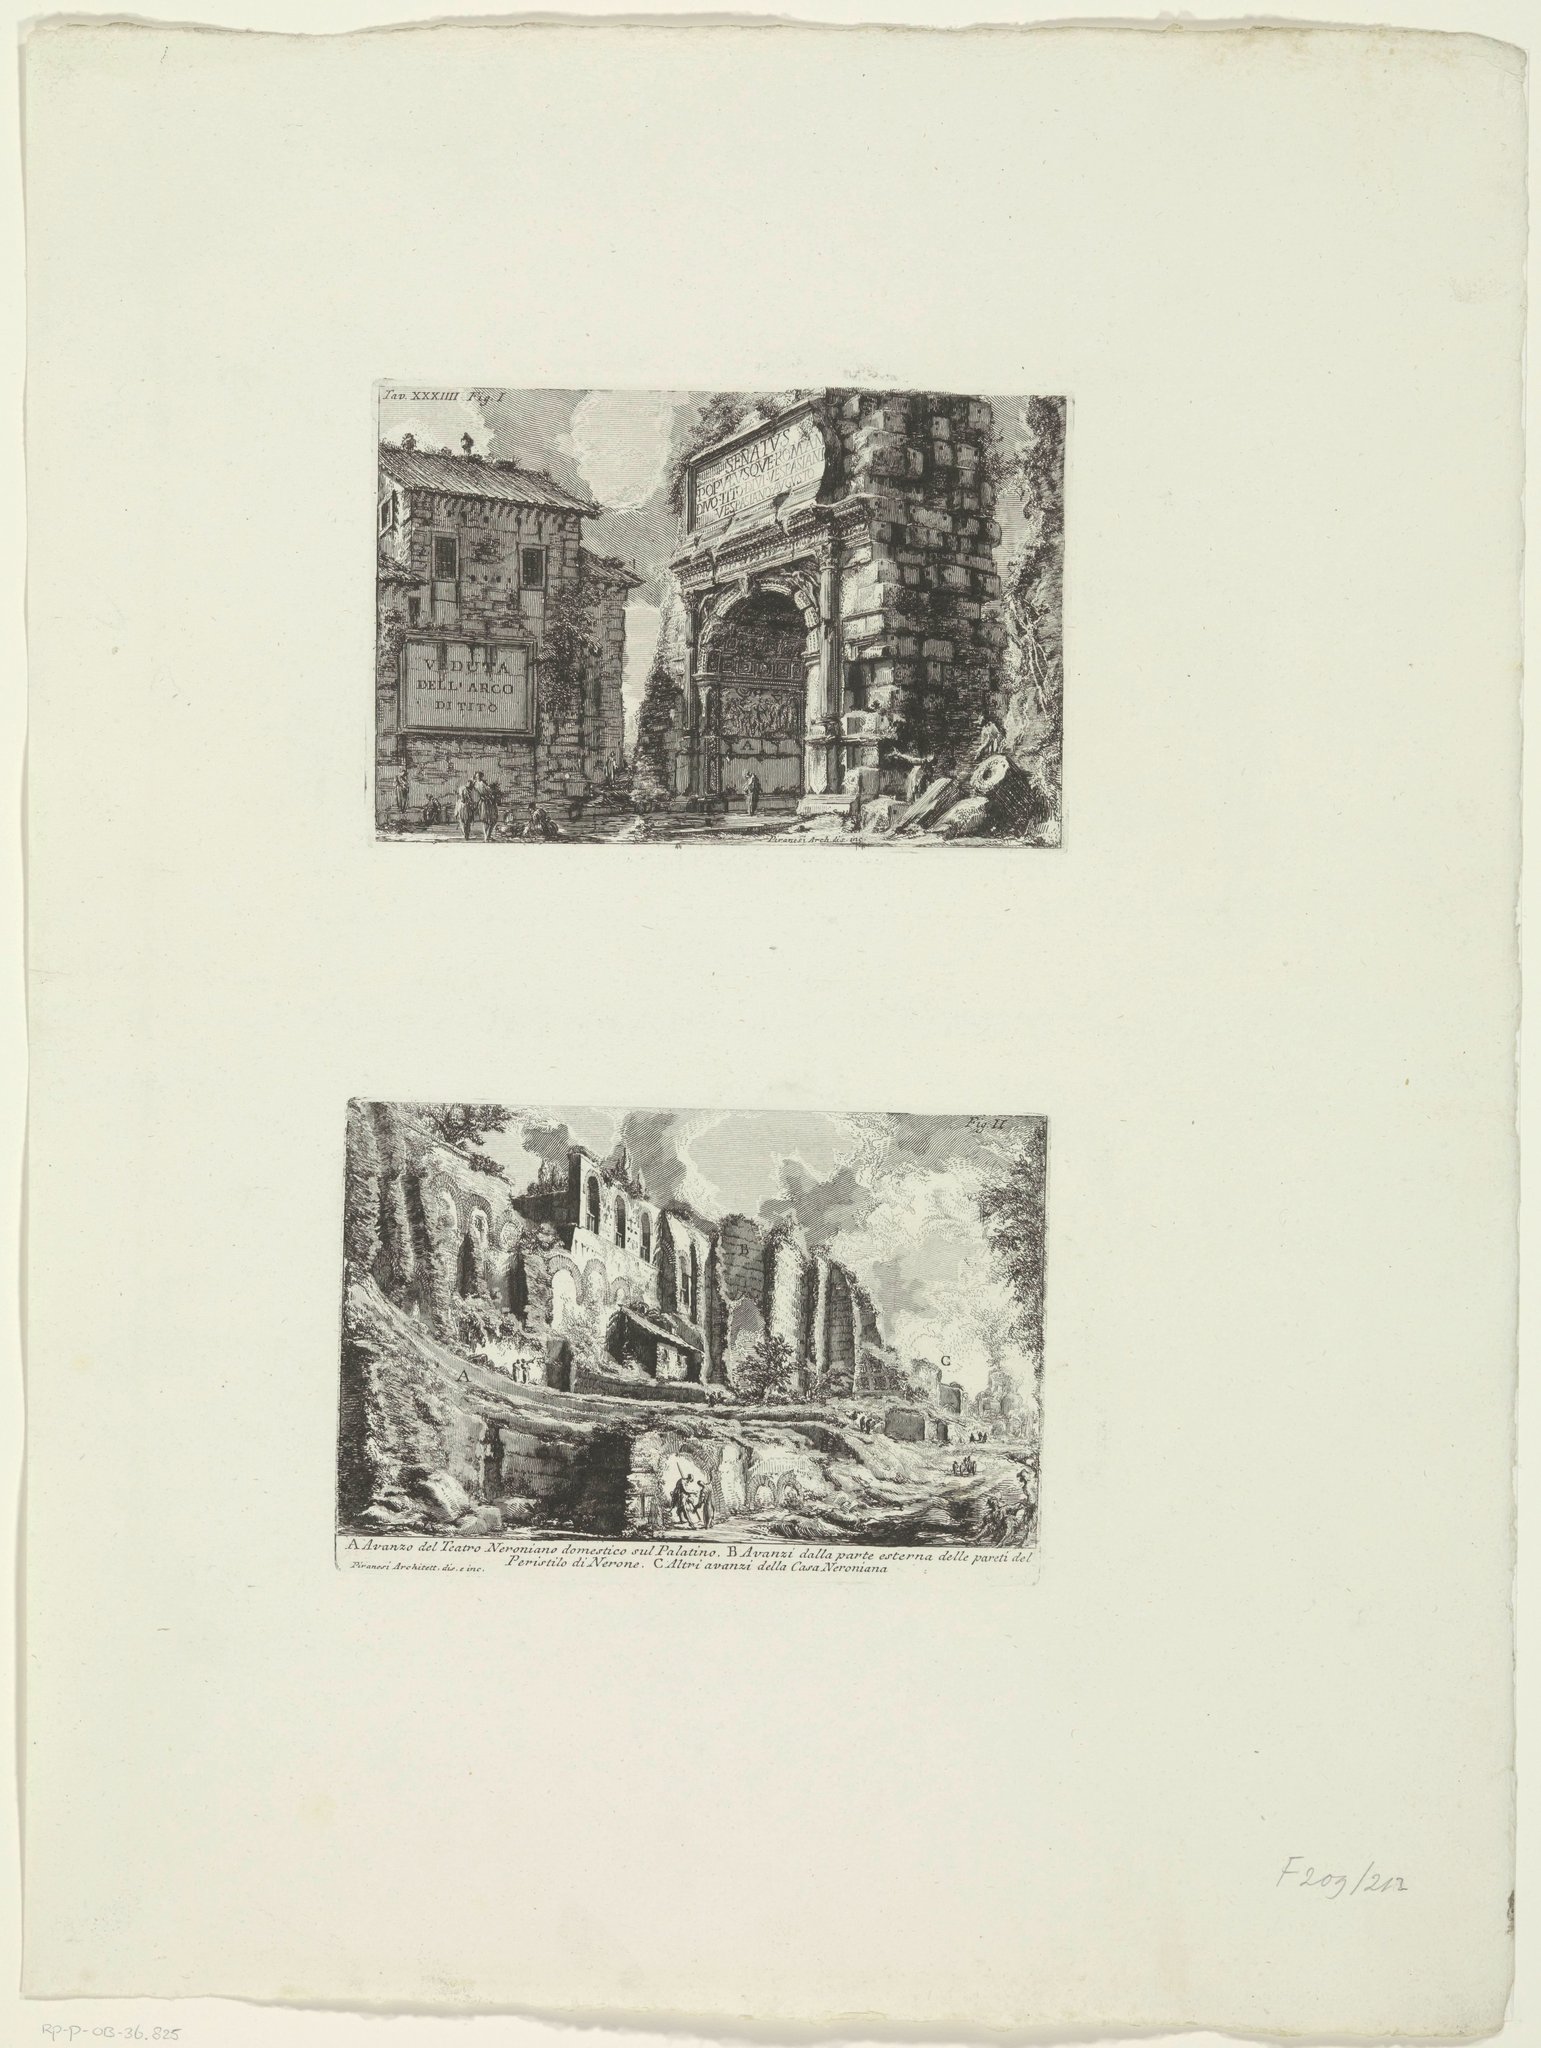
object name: print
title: Veduta dell'arco di Tito (boven)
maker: giovanni battista piranesi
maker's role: designer, draughtsman, print maker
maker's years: 1720-1778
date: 1756-1757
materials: paper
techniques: etching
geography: rome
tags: city-view, and landscape with man-made constructions, ruin of a building ~ architecture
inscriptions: collector's mark: Lugt 2228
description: Deze prenten maken deel uit van de serie 'Le Antichità Romane'. Piranesi deed meer dan acht jaar voorstudie voor deze 250 platen tellende serie die in vier volumes werd uitgegeven. Hij produceerde de prenten tussen ca. 1756 en 1757. De serie bevat ook prenten door of naar andere prentmakers, onder wie Francesco Bianchini en Girolamo Rossi.